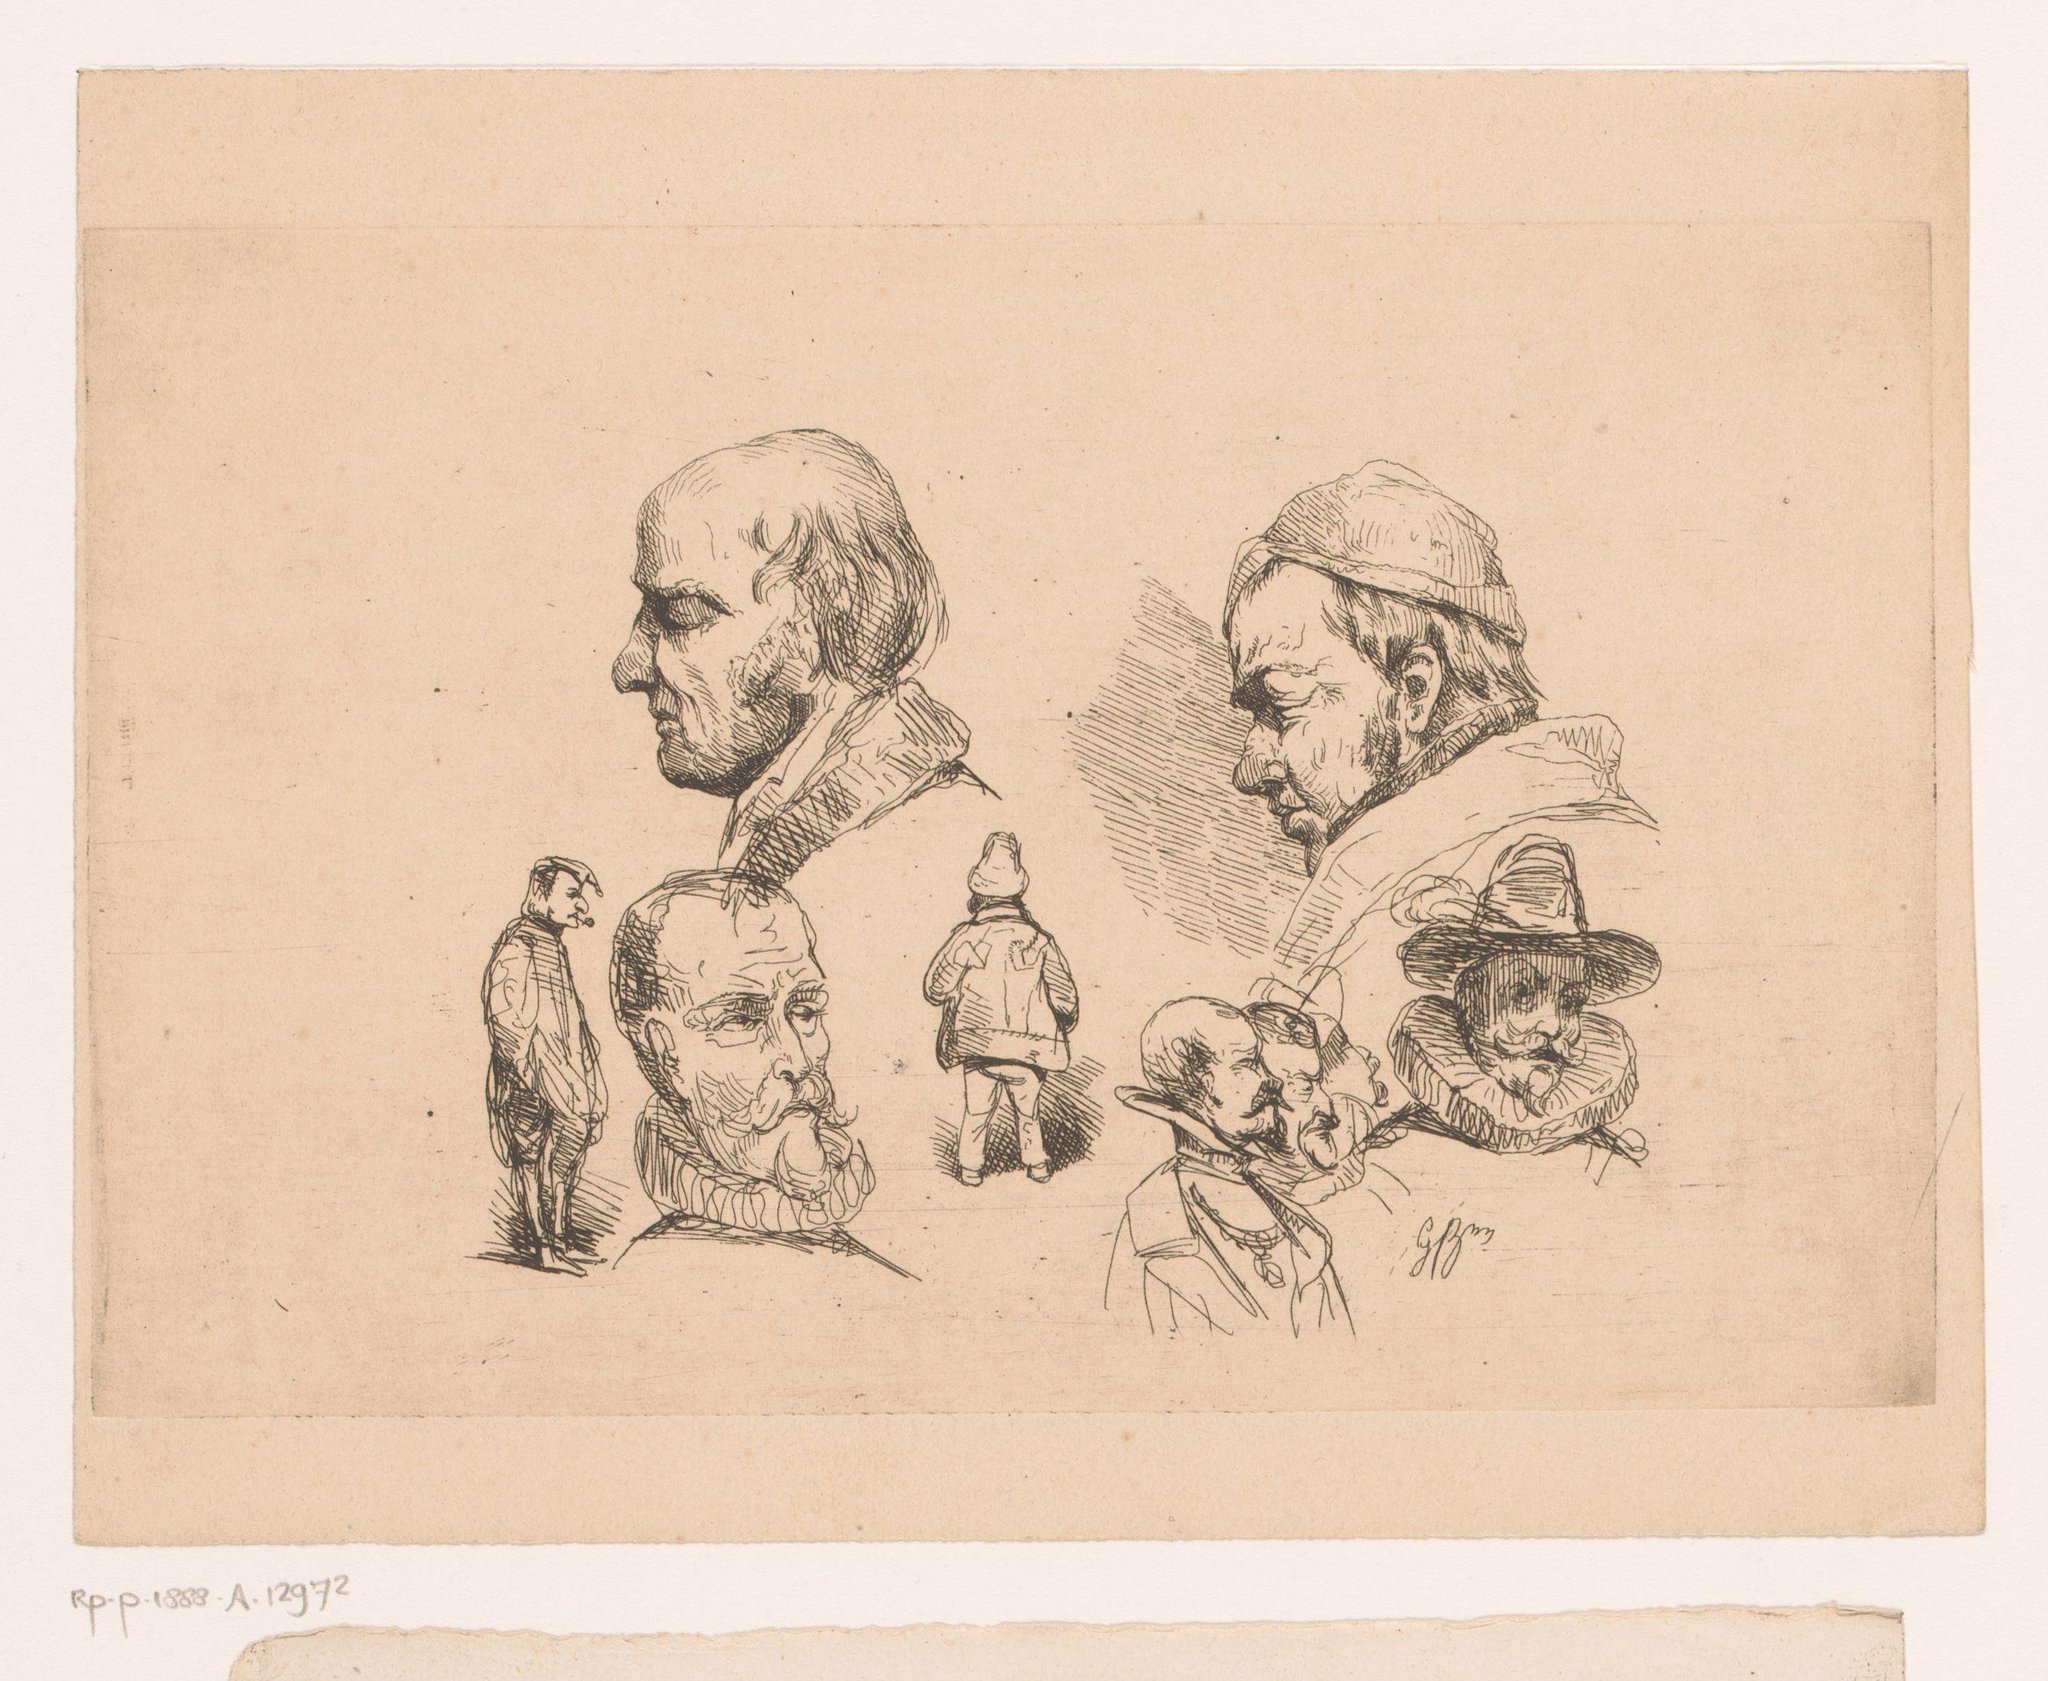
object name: print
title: Zeven portretstudies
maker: gustave buschmann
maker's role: print maker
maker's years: 1818-1852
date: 1828-1852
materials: paper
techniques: etching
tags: anonymous historical person portrayed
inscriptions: collector's mark: Lugt 2228